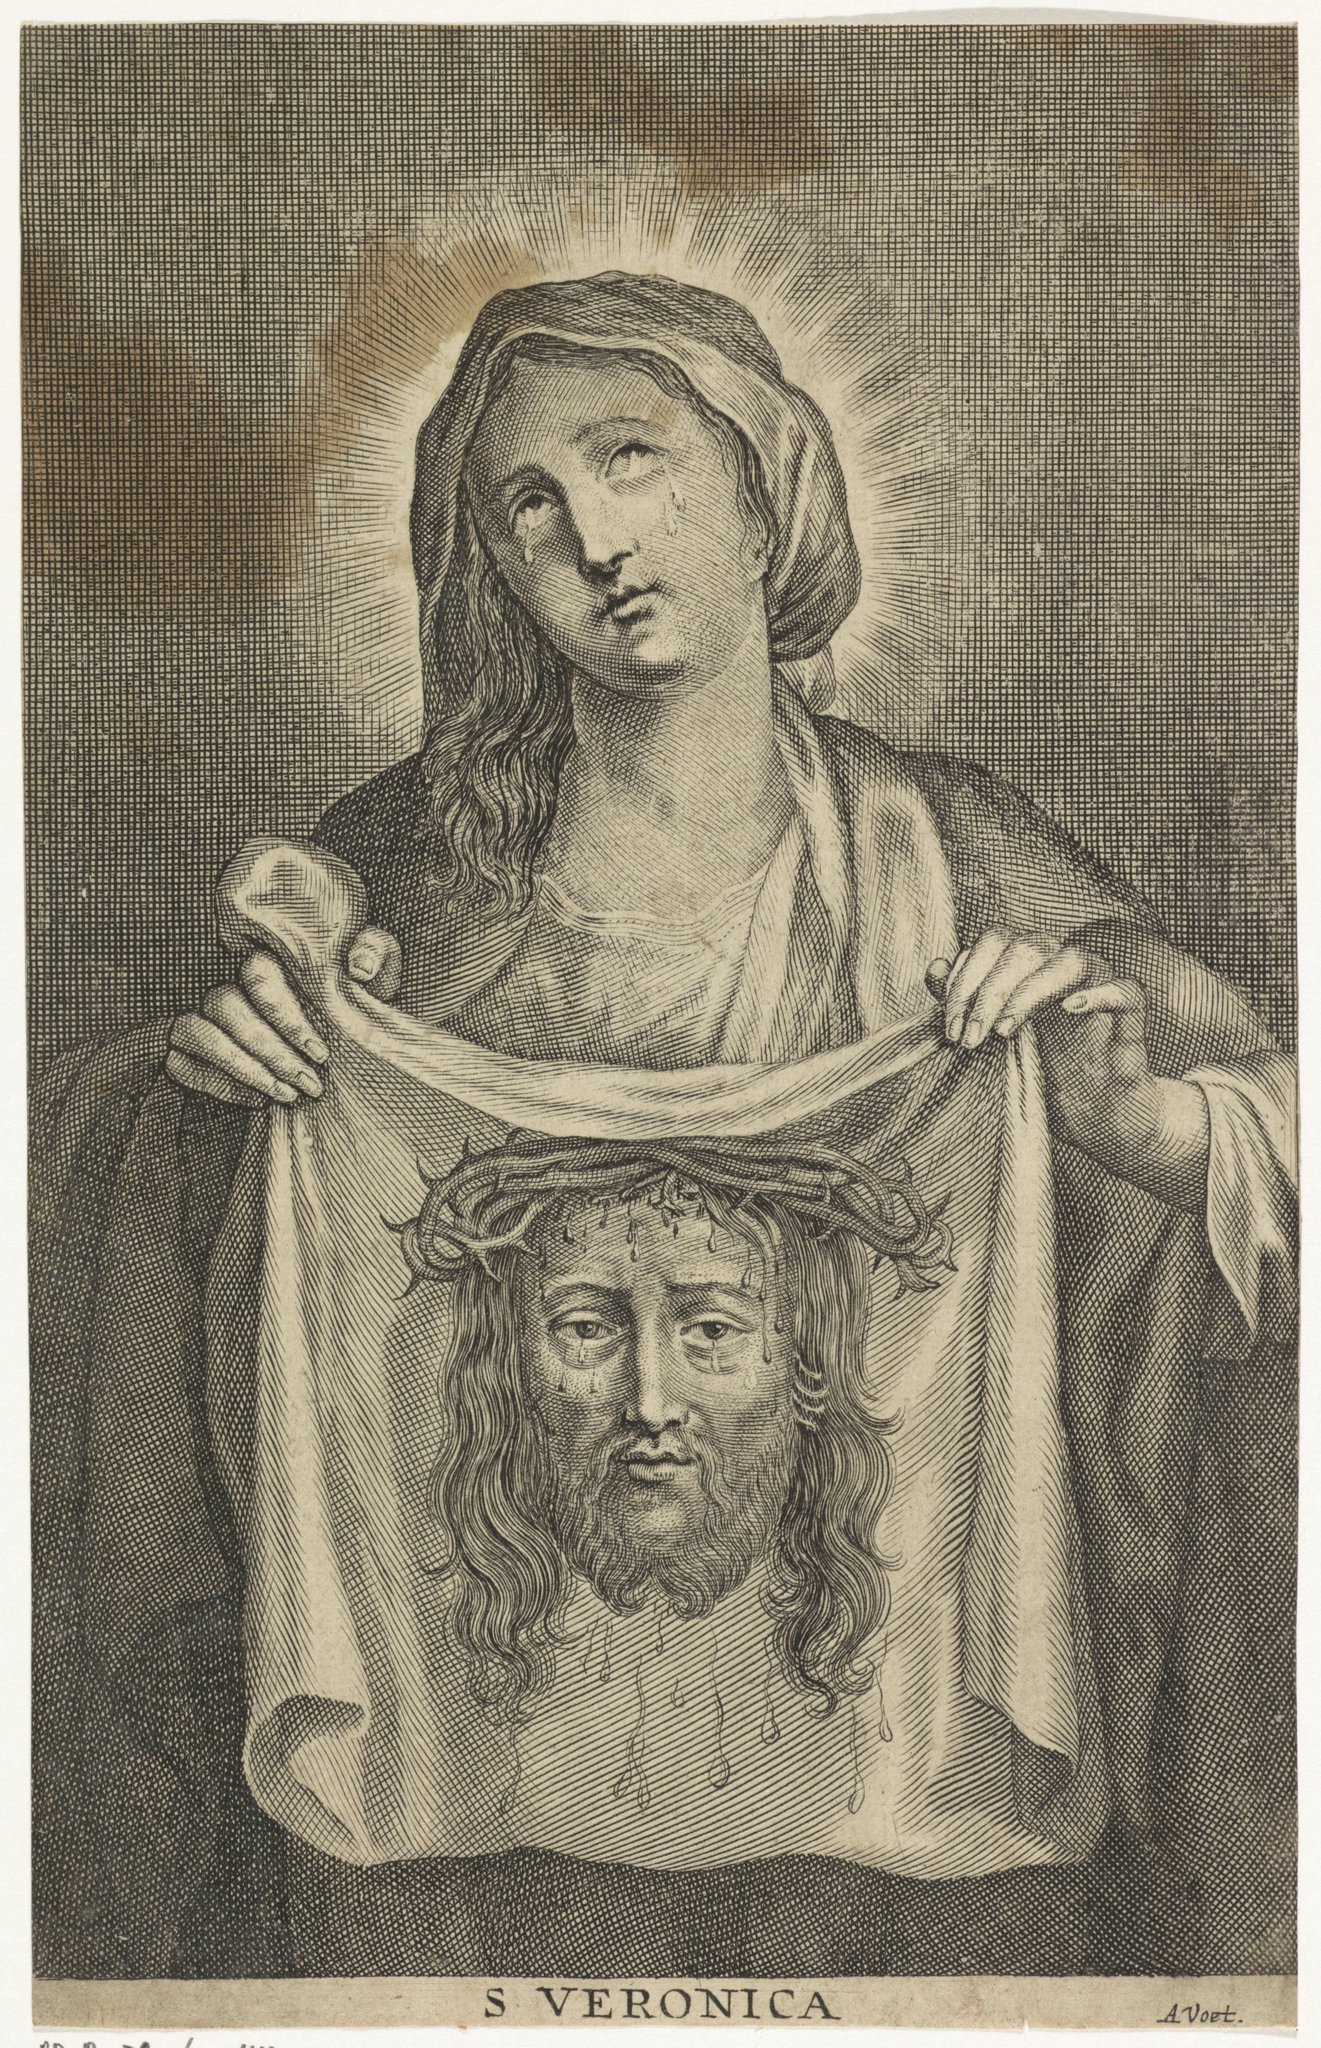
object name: print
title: H. Veronica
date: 1628-1689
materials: paper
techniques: engraving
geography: antwerp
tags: veronica; possible attributes: 'sudarium' (veil with the image of christ)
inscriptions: collector's mark: Lugt 2228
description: De heilige Veronica met de zweetdoek met daarop de beeltenis van Christus.